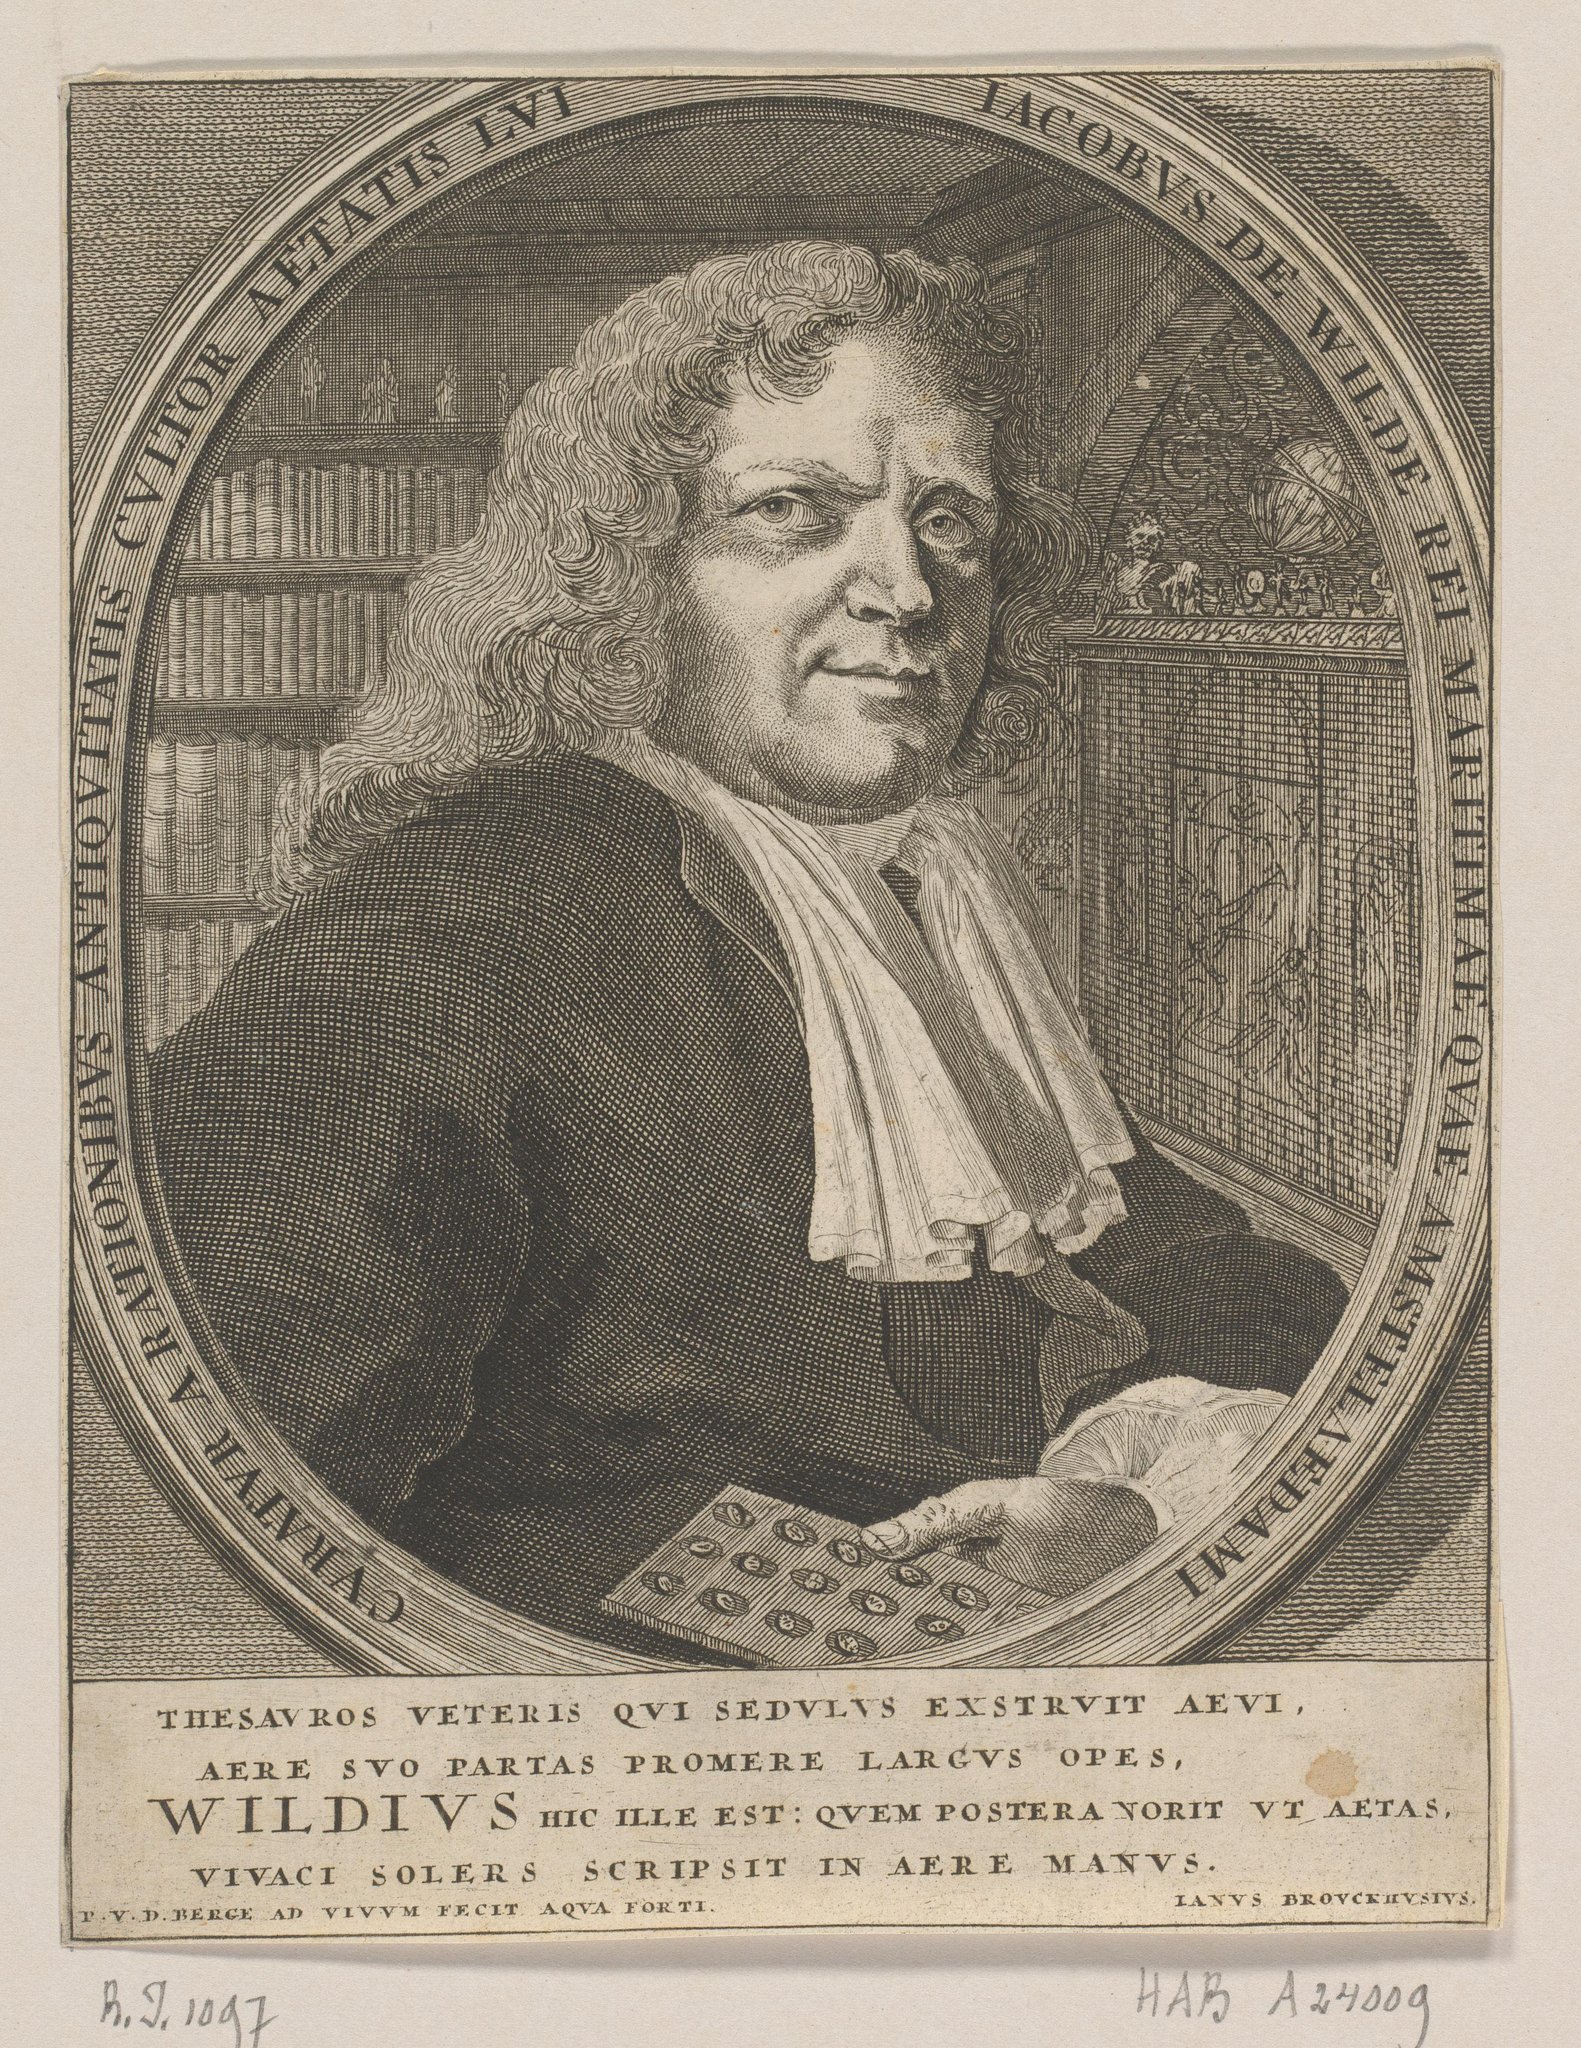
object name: print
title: Portret van Jacob de Wilde op 56-jarige leeftijd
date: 1701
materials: paper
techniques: engraving, etching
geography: amsterdam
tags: the hague, amsterdam, jacob de wilde, historical persons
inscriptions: collector's mark: Lugt 2228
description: Met vierregelig onderschrift in het Latijn en tekst in het Latijn rondom het portret.